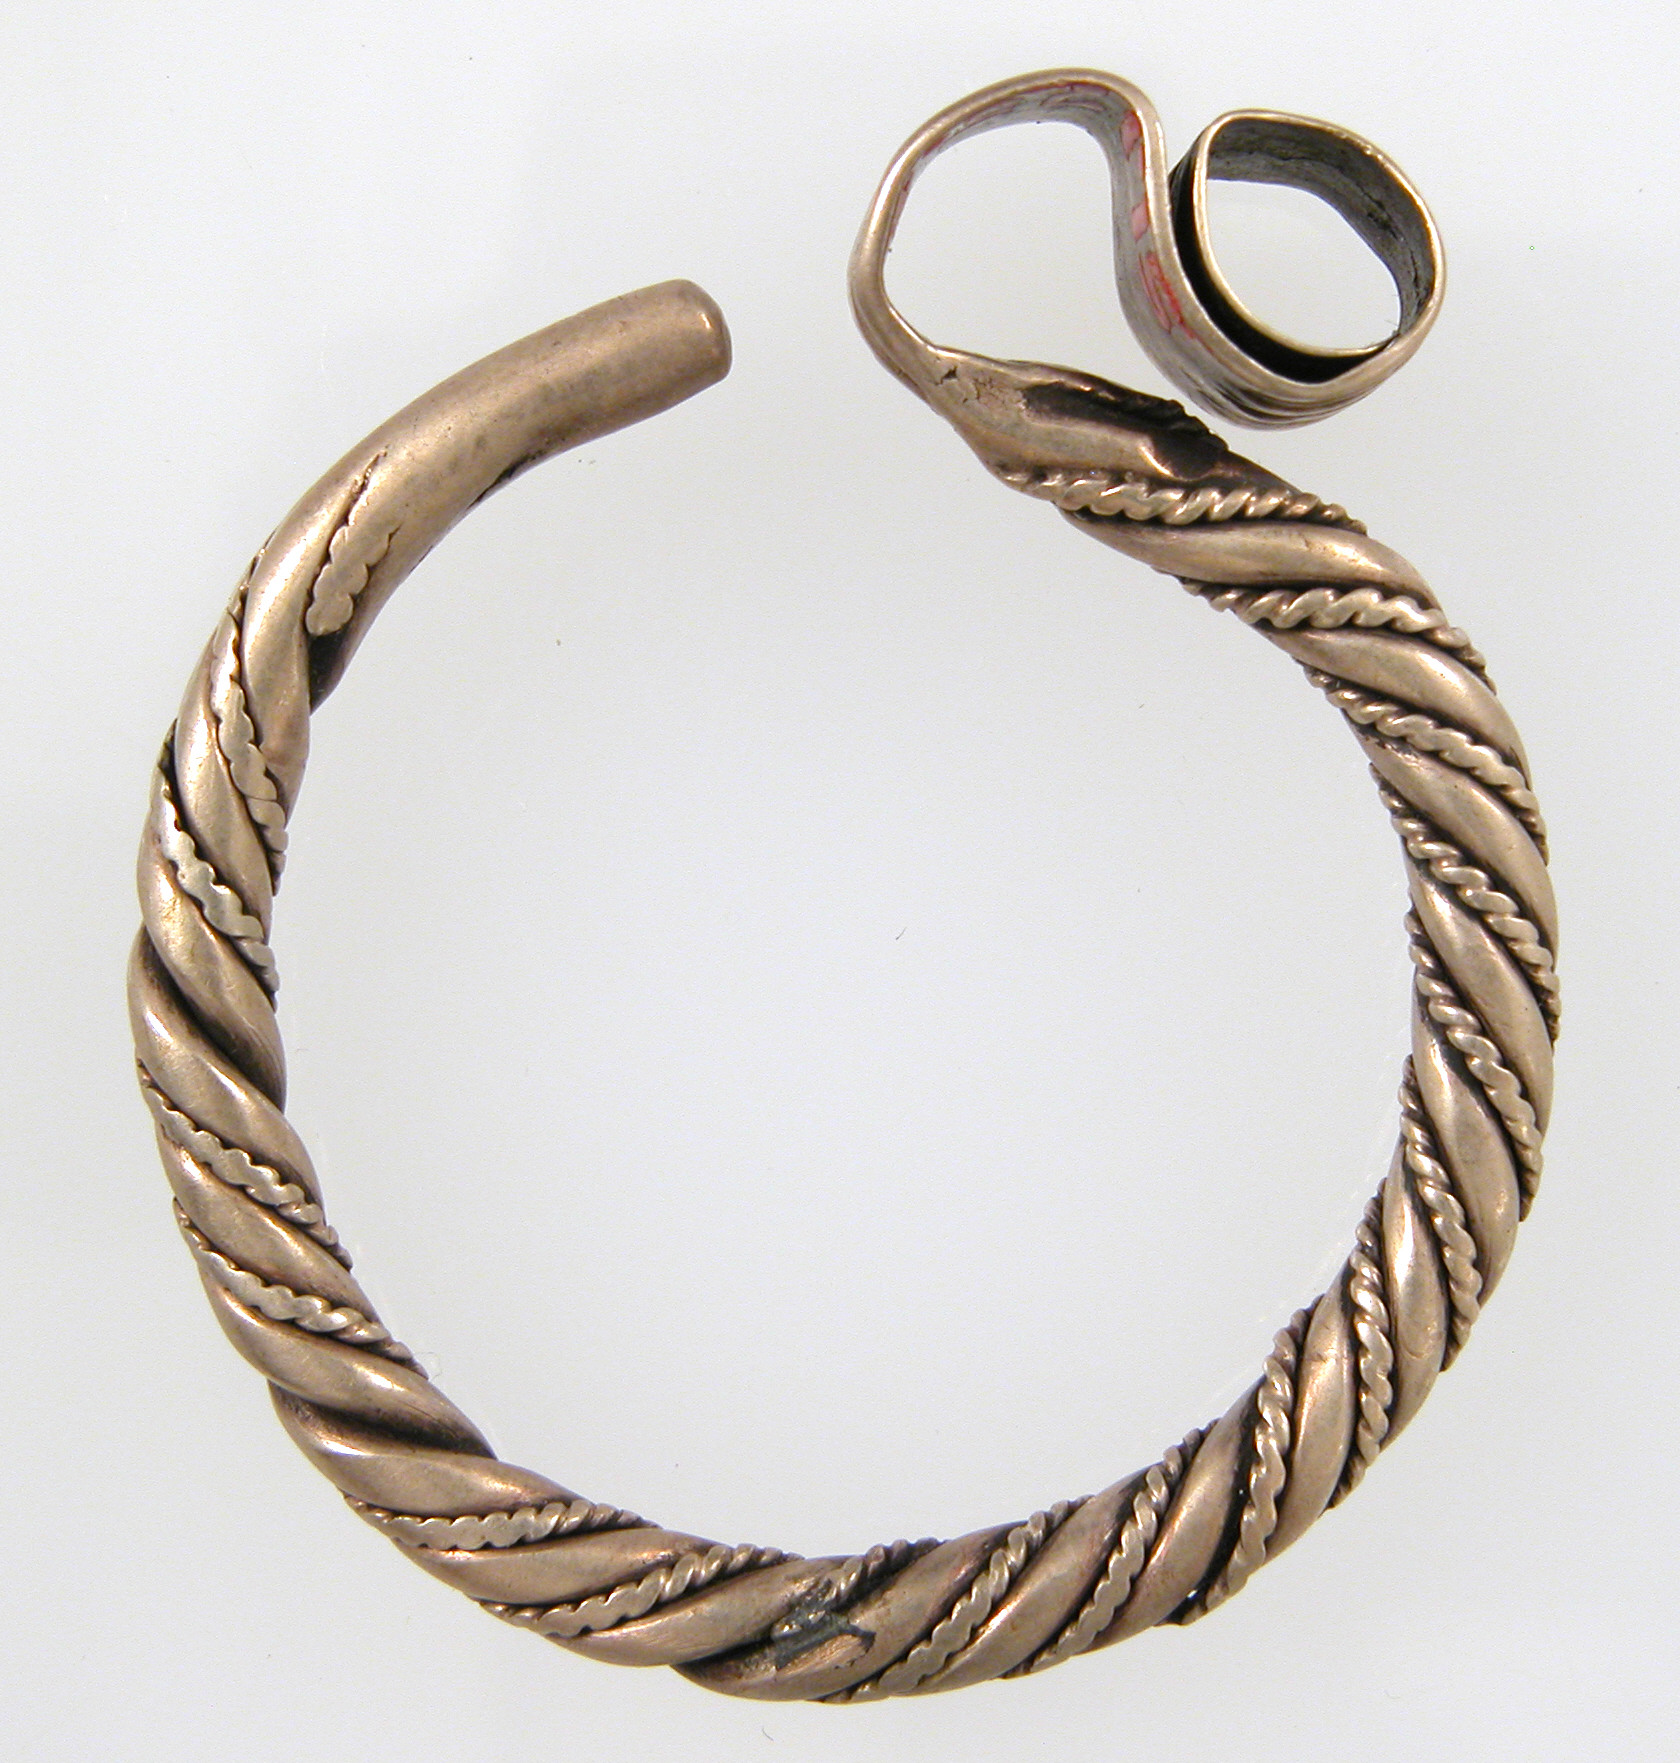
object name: earring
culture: viking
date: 801-1000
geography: scandinavia